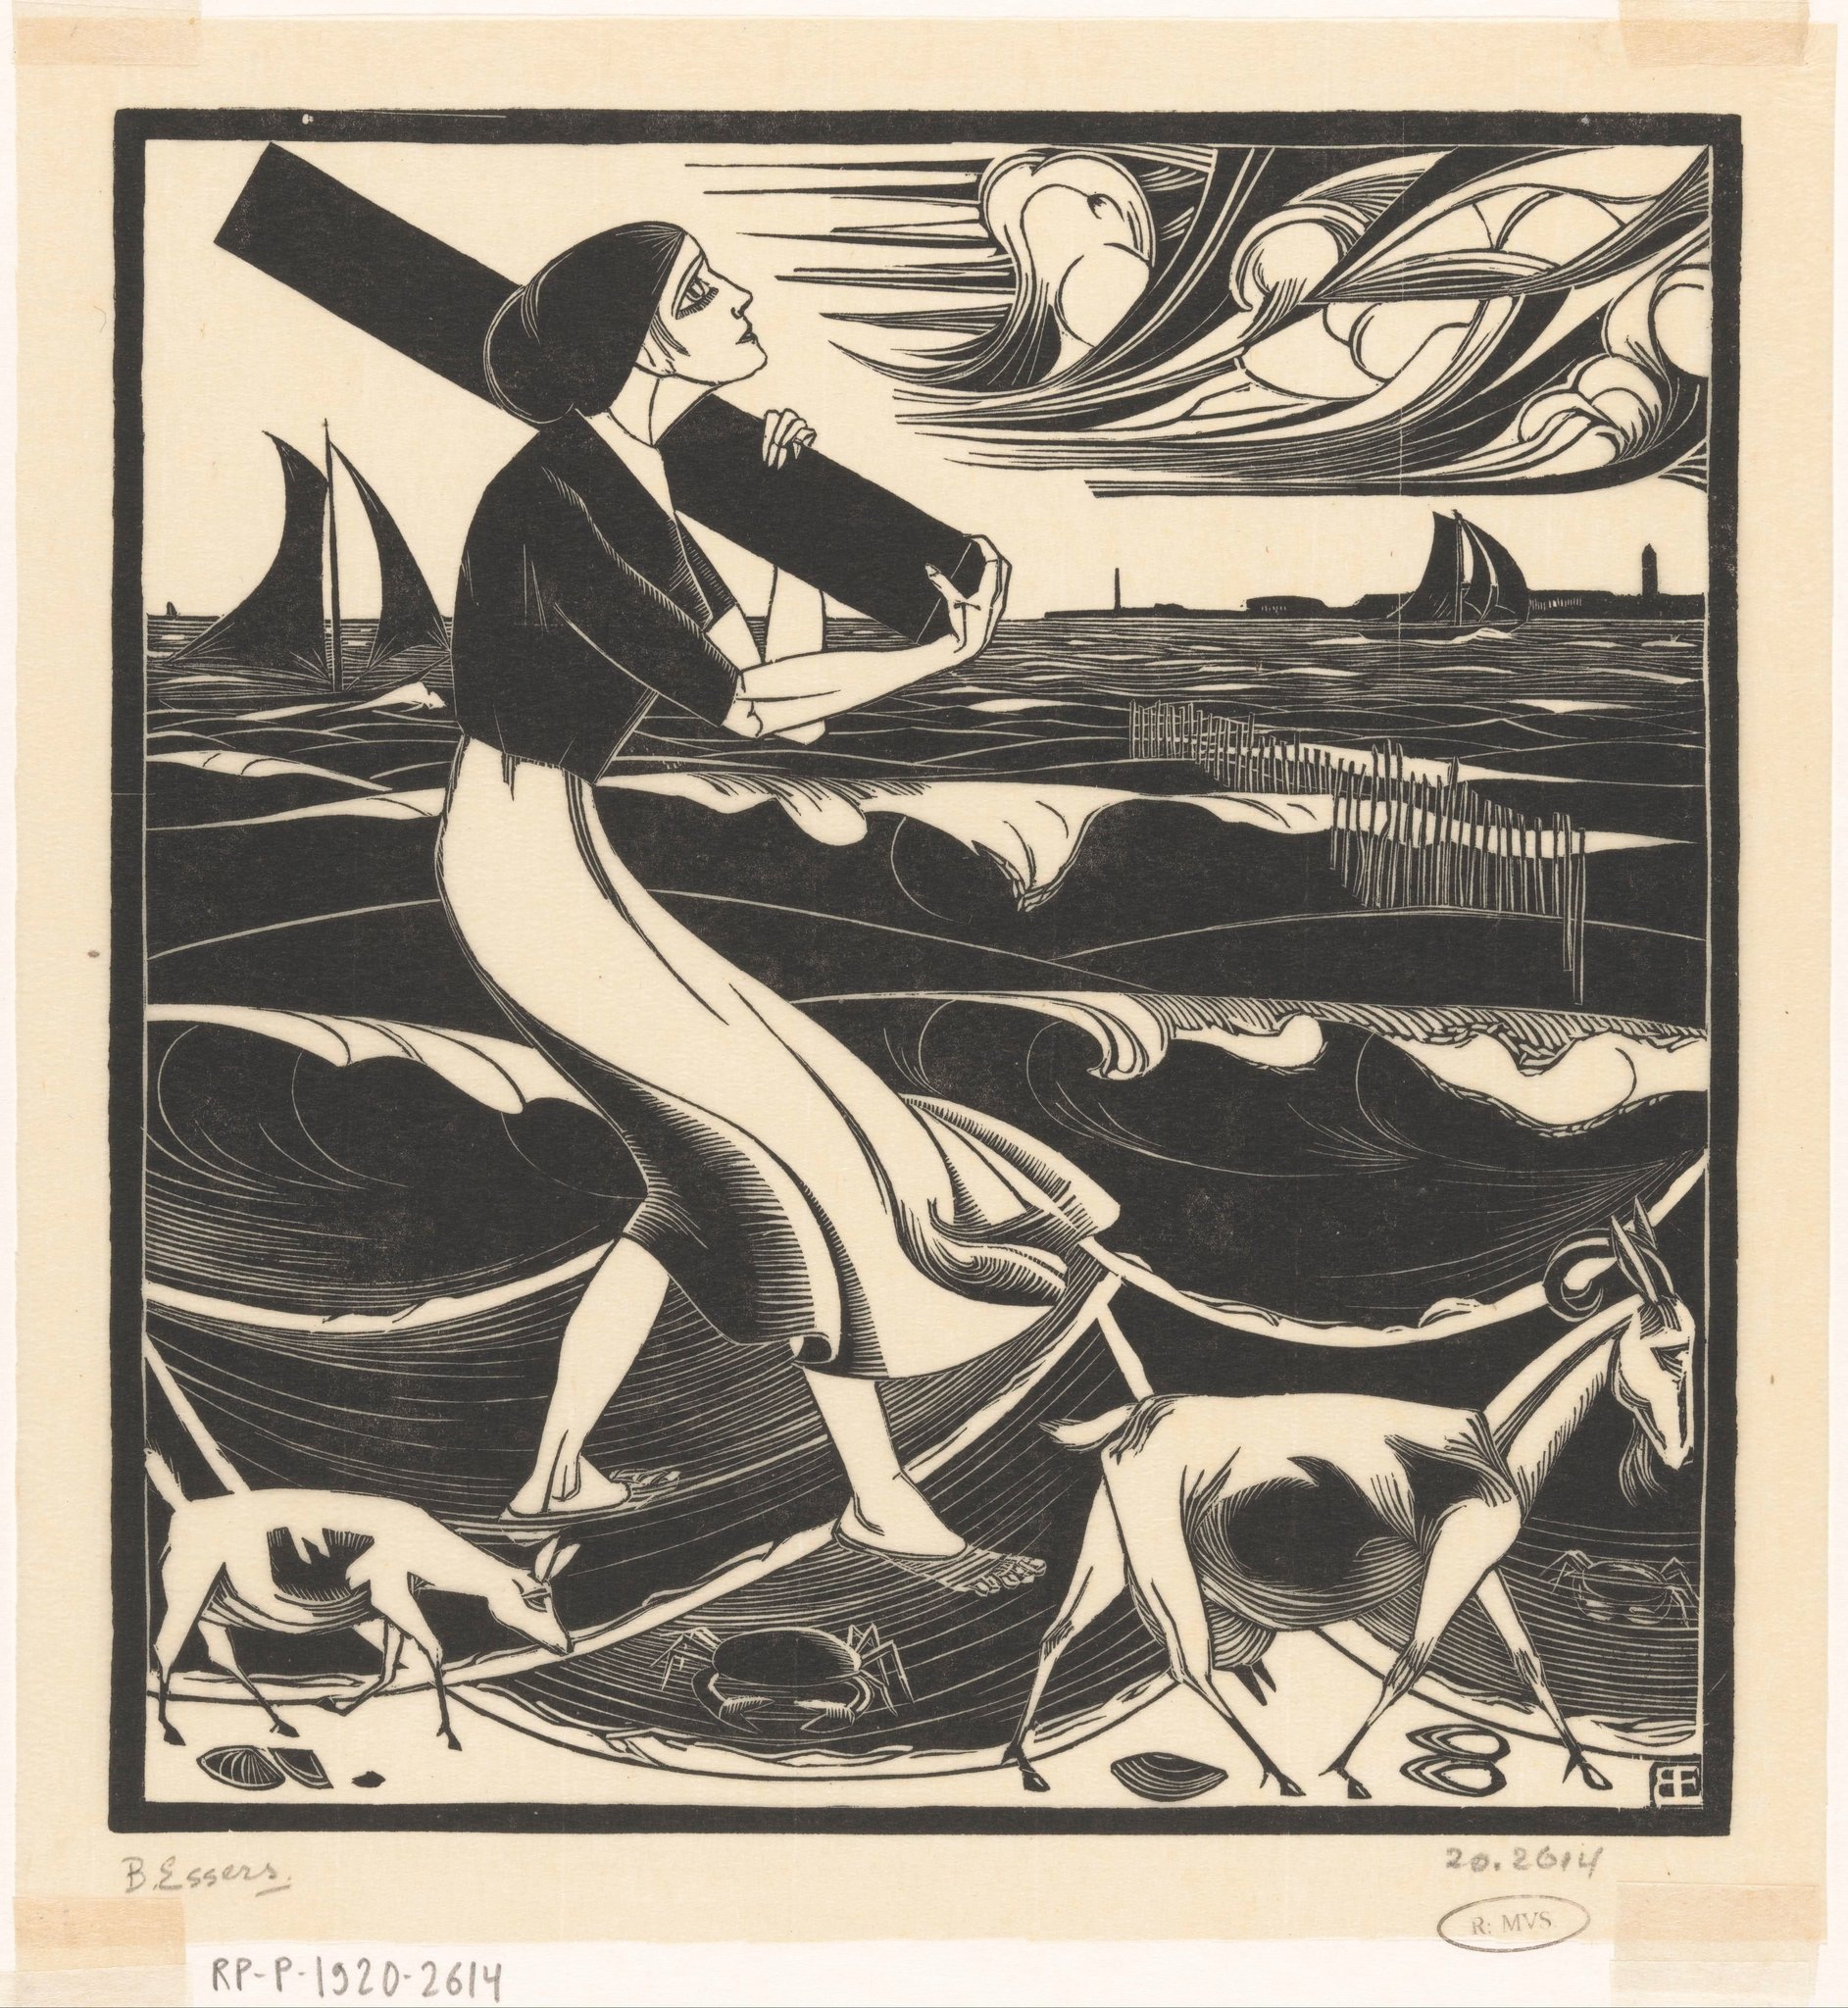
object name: print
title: Strand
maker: bernard essers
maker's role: print maker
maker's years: 1893-1945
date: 1919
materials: paper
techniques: engraving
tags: goat, beach, carrying something on the head or on the shoulders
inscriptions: collector's mark: Lugt 2228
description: Een vrouw op het strand draagt een cilindervormig object op haar schouder. Naast haar een geit, een bok en twee krabben. In het water een paalhoofd en zeilschepen.